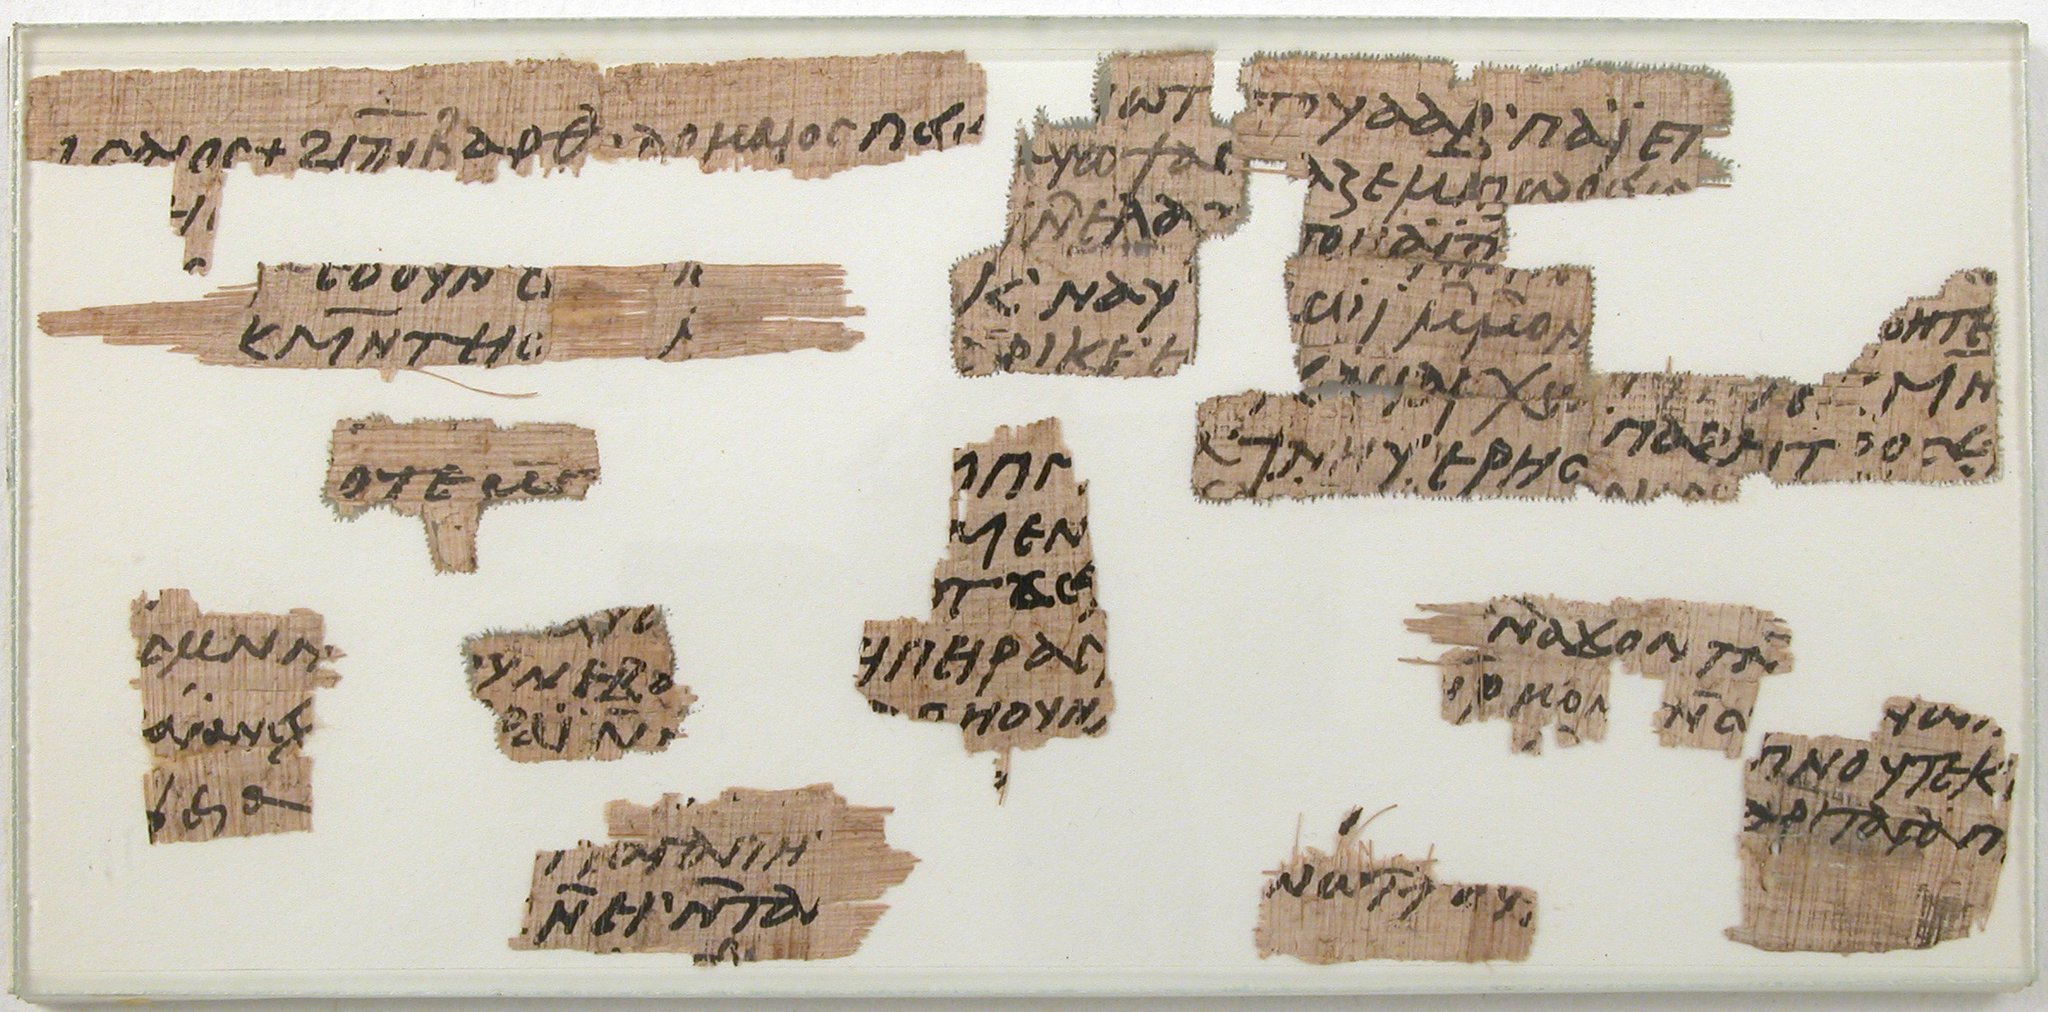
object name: fragment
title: Papyri Fragments of a Letter from Bartholomew to Elisasius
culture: coptic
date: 601-700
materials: ink, papyrus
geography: egypt